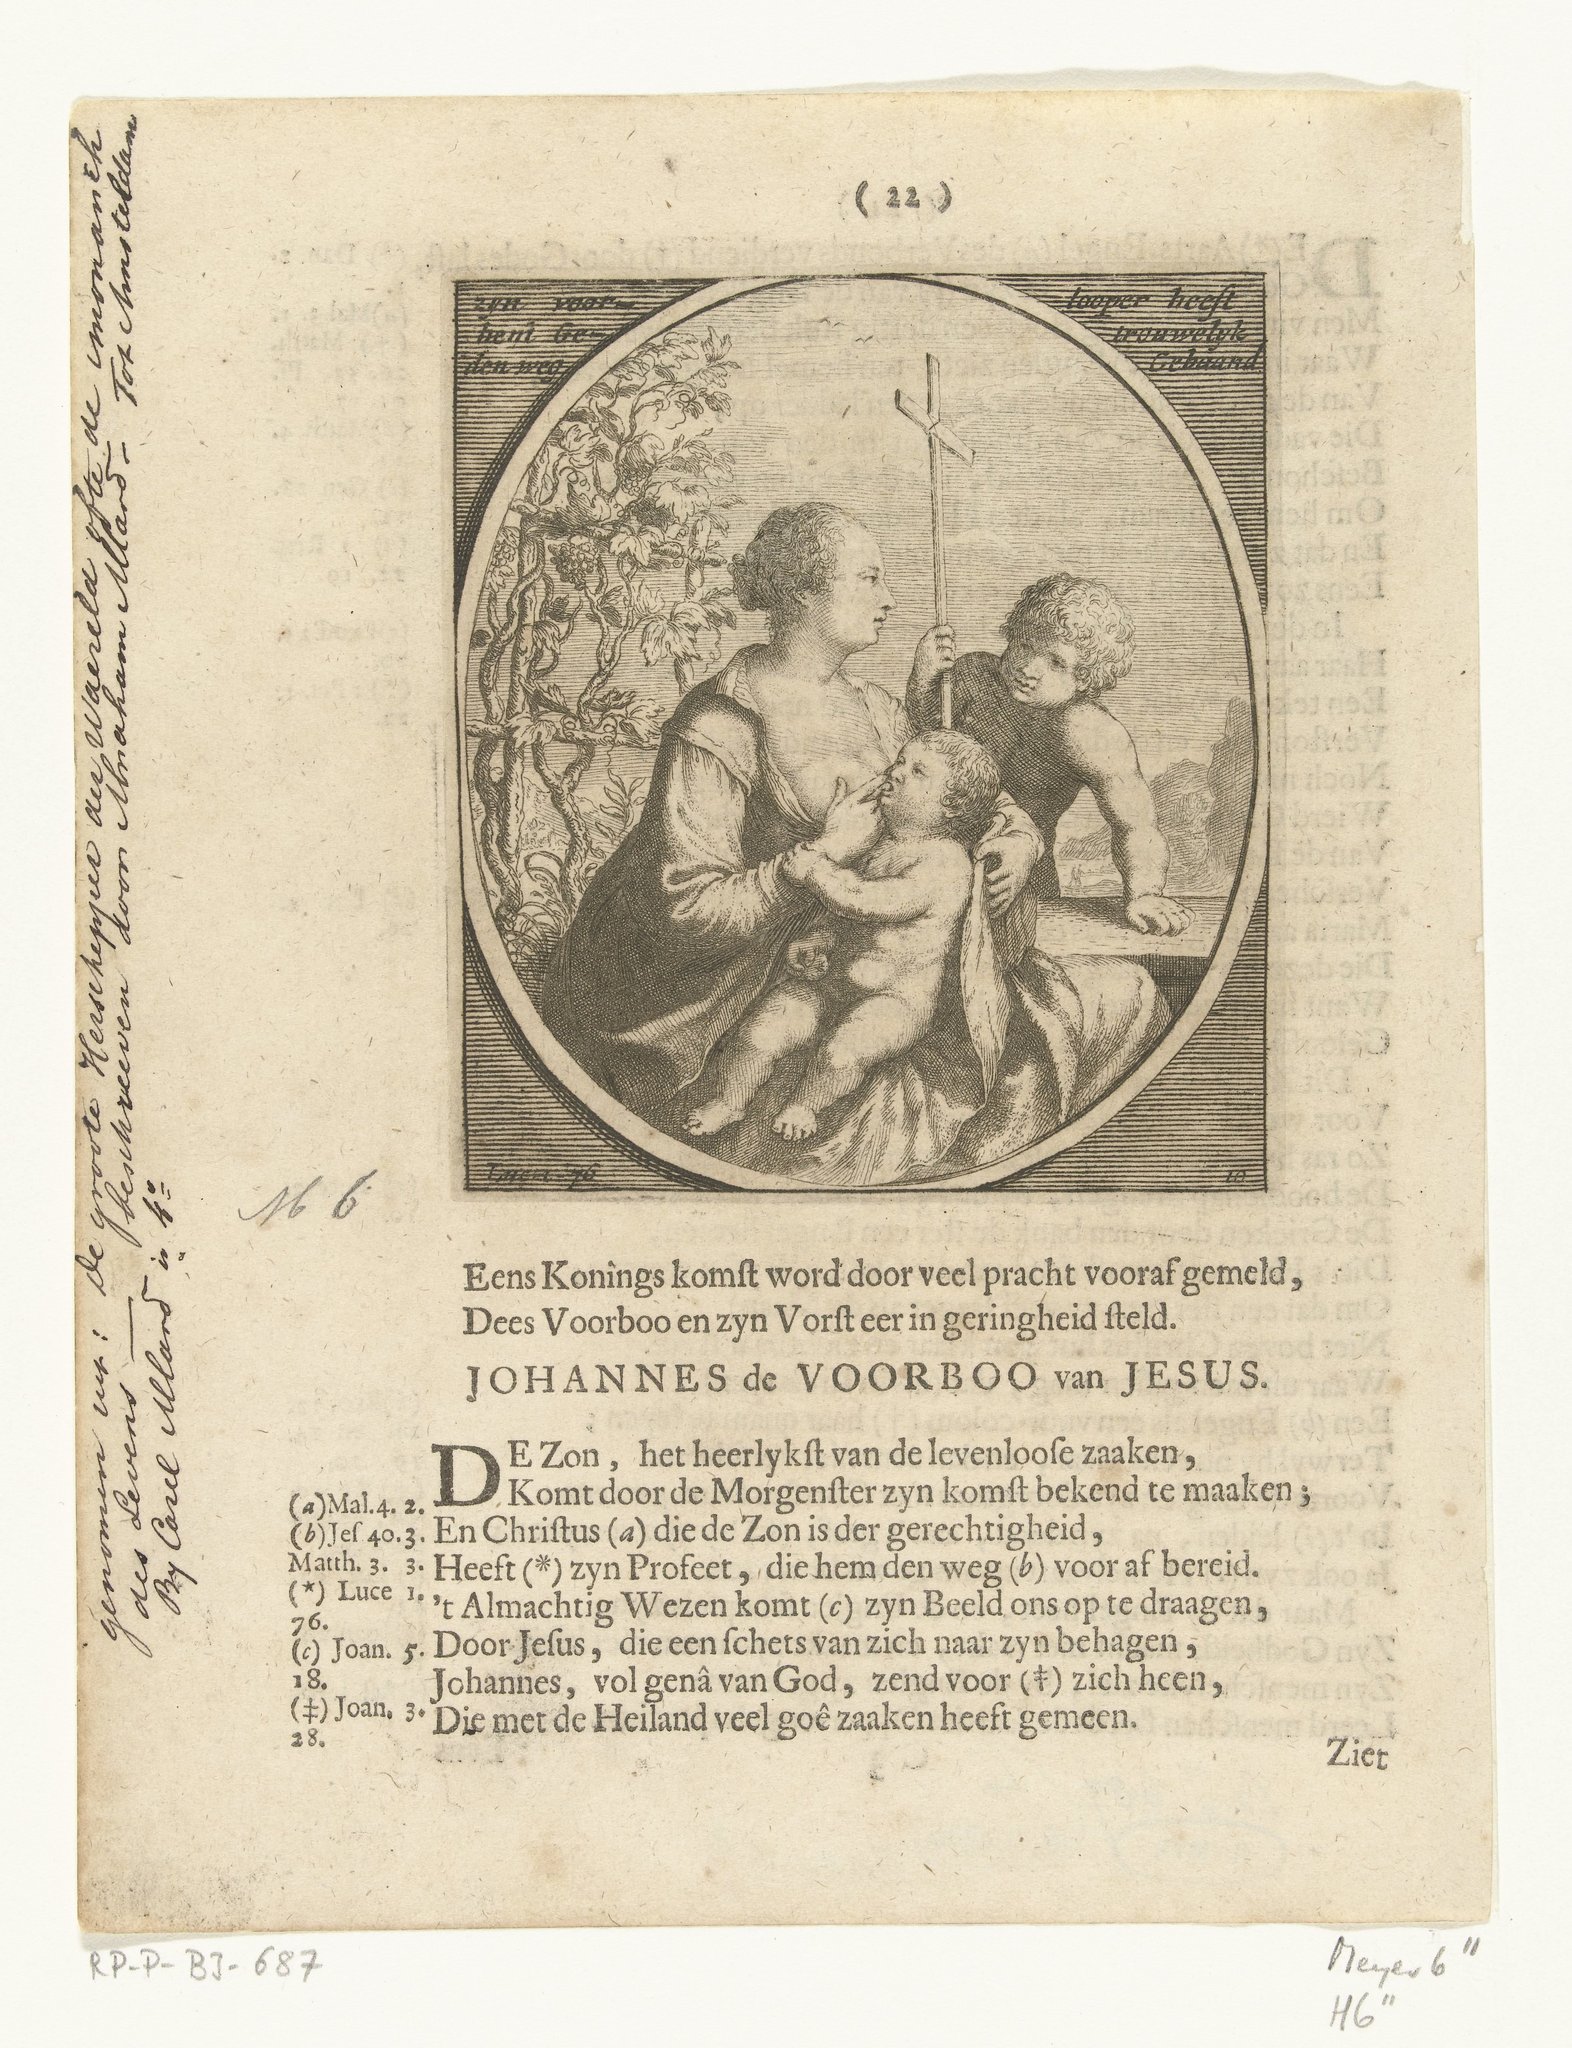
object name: book illustration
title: Maria met Christus en Johannes de Doper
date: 1633-1672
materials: paper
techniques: etching, letterpress printing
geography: amsterdam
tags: madonna: mary standing (or half-length), christ-child close to her bosom, john the baptist as child ~ madonna-representations (n.b. secondary notation only)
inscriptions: collector's mark: Lugt 2228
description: Bladzijde uit een boek. Maria geeft Christus de borst. Johannes de Doper met het kruis staat achter hen. Onder de voorstelling en aan het verso tekst in boekdruk.